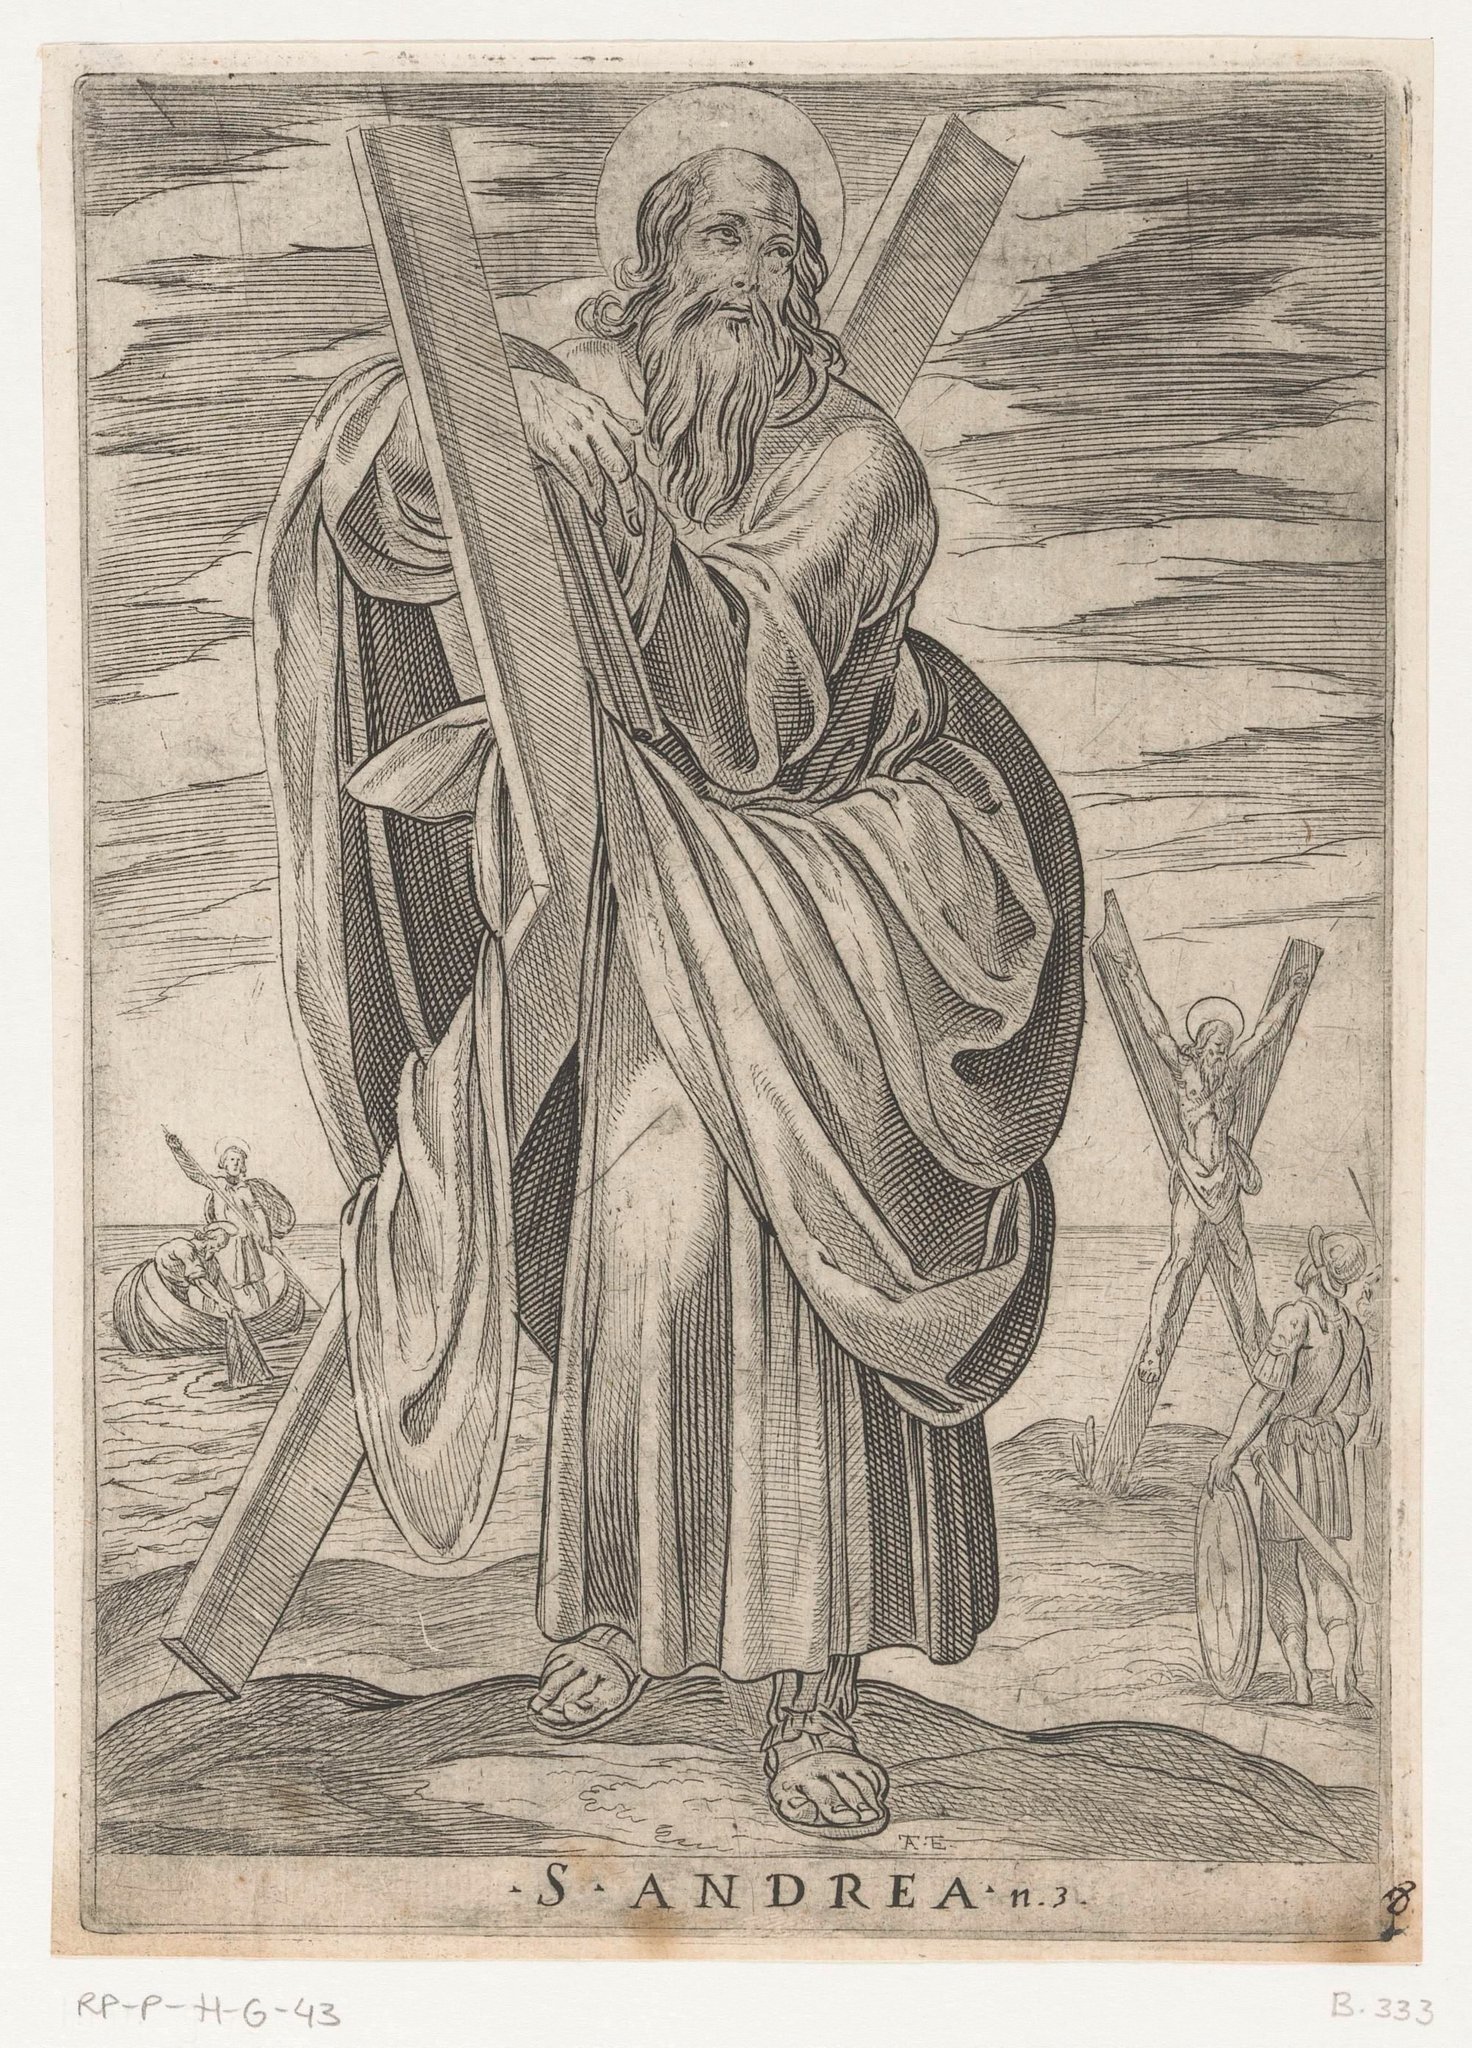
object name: print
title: De heilige Andreas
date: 1565-1630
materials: paper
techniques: etching, intaglio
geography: italy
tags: the apostle andrew; possible attributes: book, x-shaped cross, fish, fishing-net, rope, scroll, crucifixion of andrew: he is undressed and tied to the cross, calling of peter and andrew; they are called away from their fishing-boat (matthew 4:18-20; mark 1:16-18)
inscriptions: collector's mark: Lugt 11, number: ‘8’, collector's mark: ‘Hinloopen’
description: De heilige Andreas met Andreaskruis. Op de achtergrond links de heilige Andreas vissend in een boot op zee. Op de achtergrond rechts de kruisiging van de heilige Andreas.